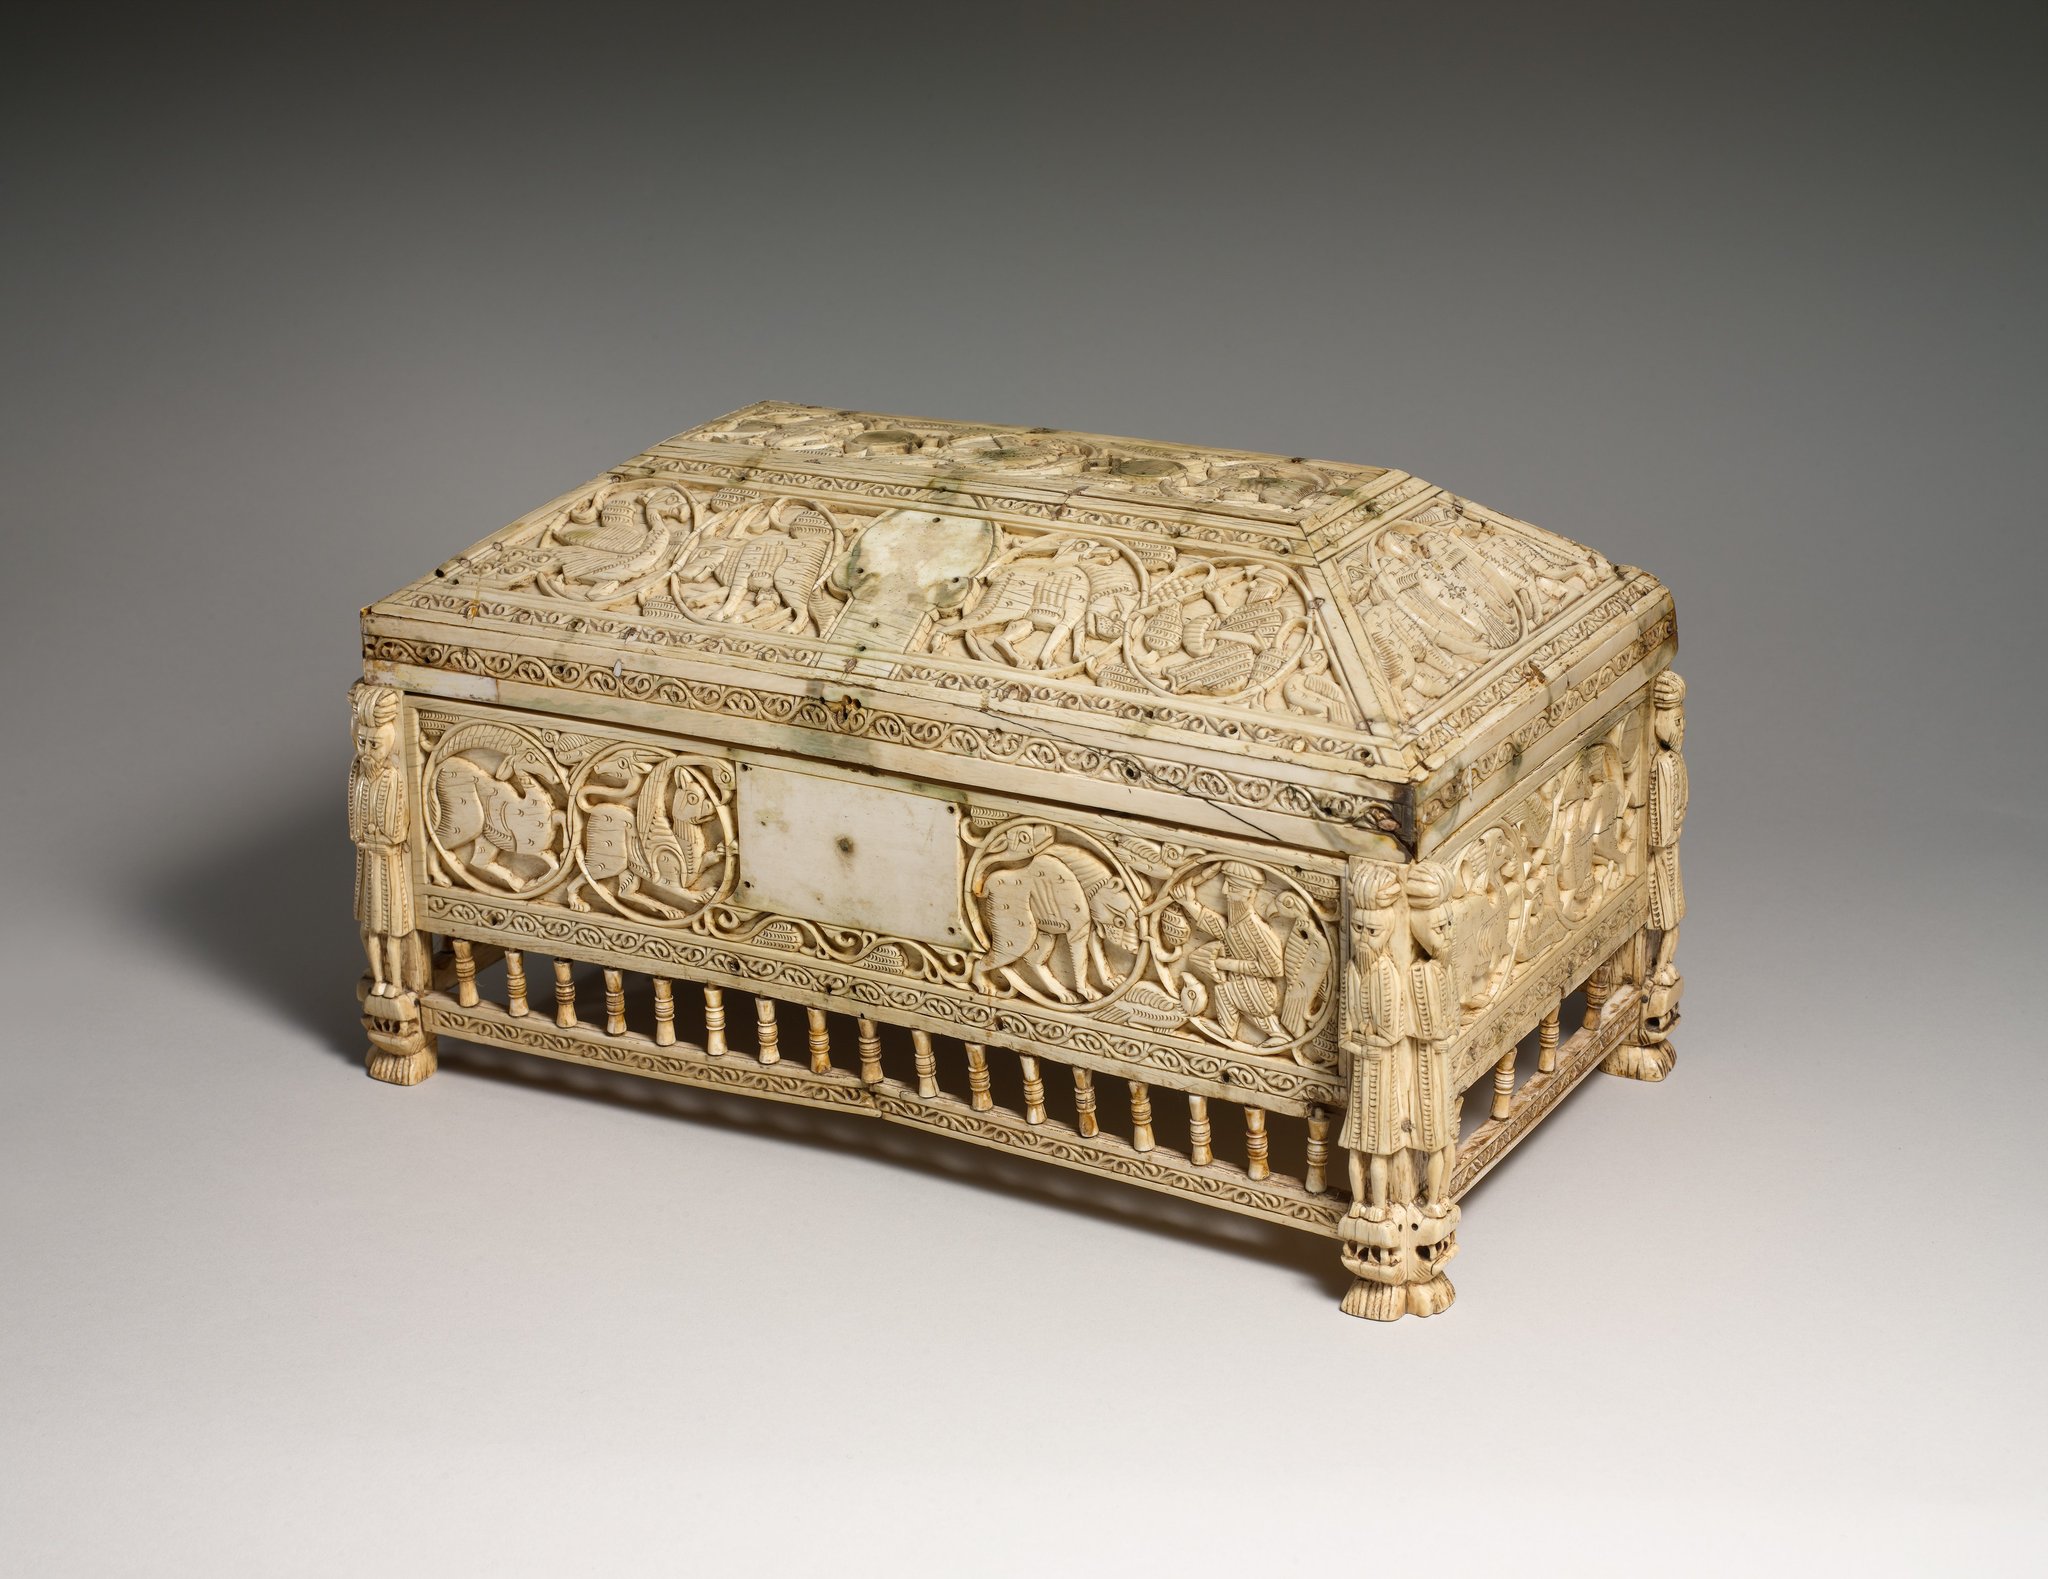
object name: casket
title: Morgan Casket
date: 1001-1200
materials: ivory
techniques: carving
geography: italy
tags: animals,birds,men